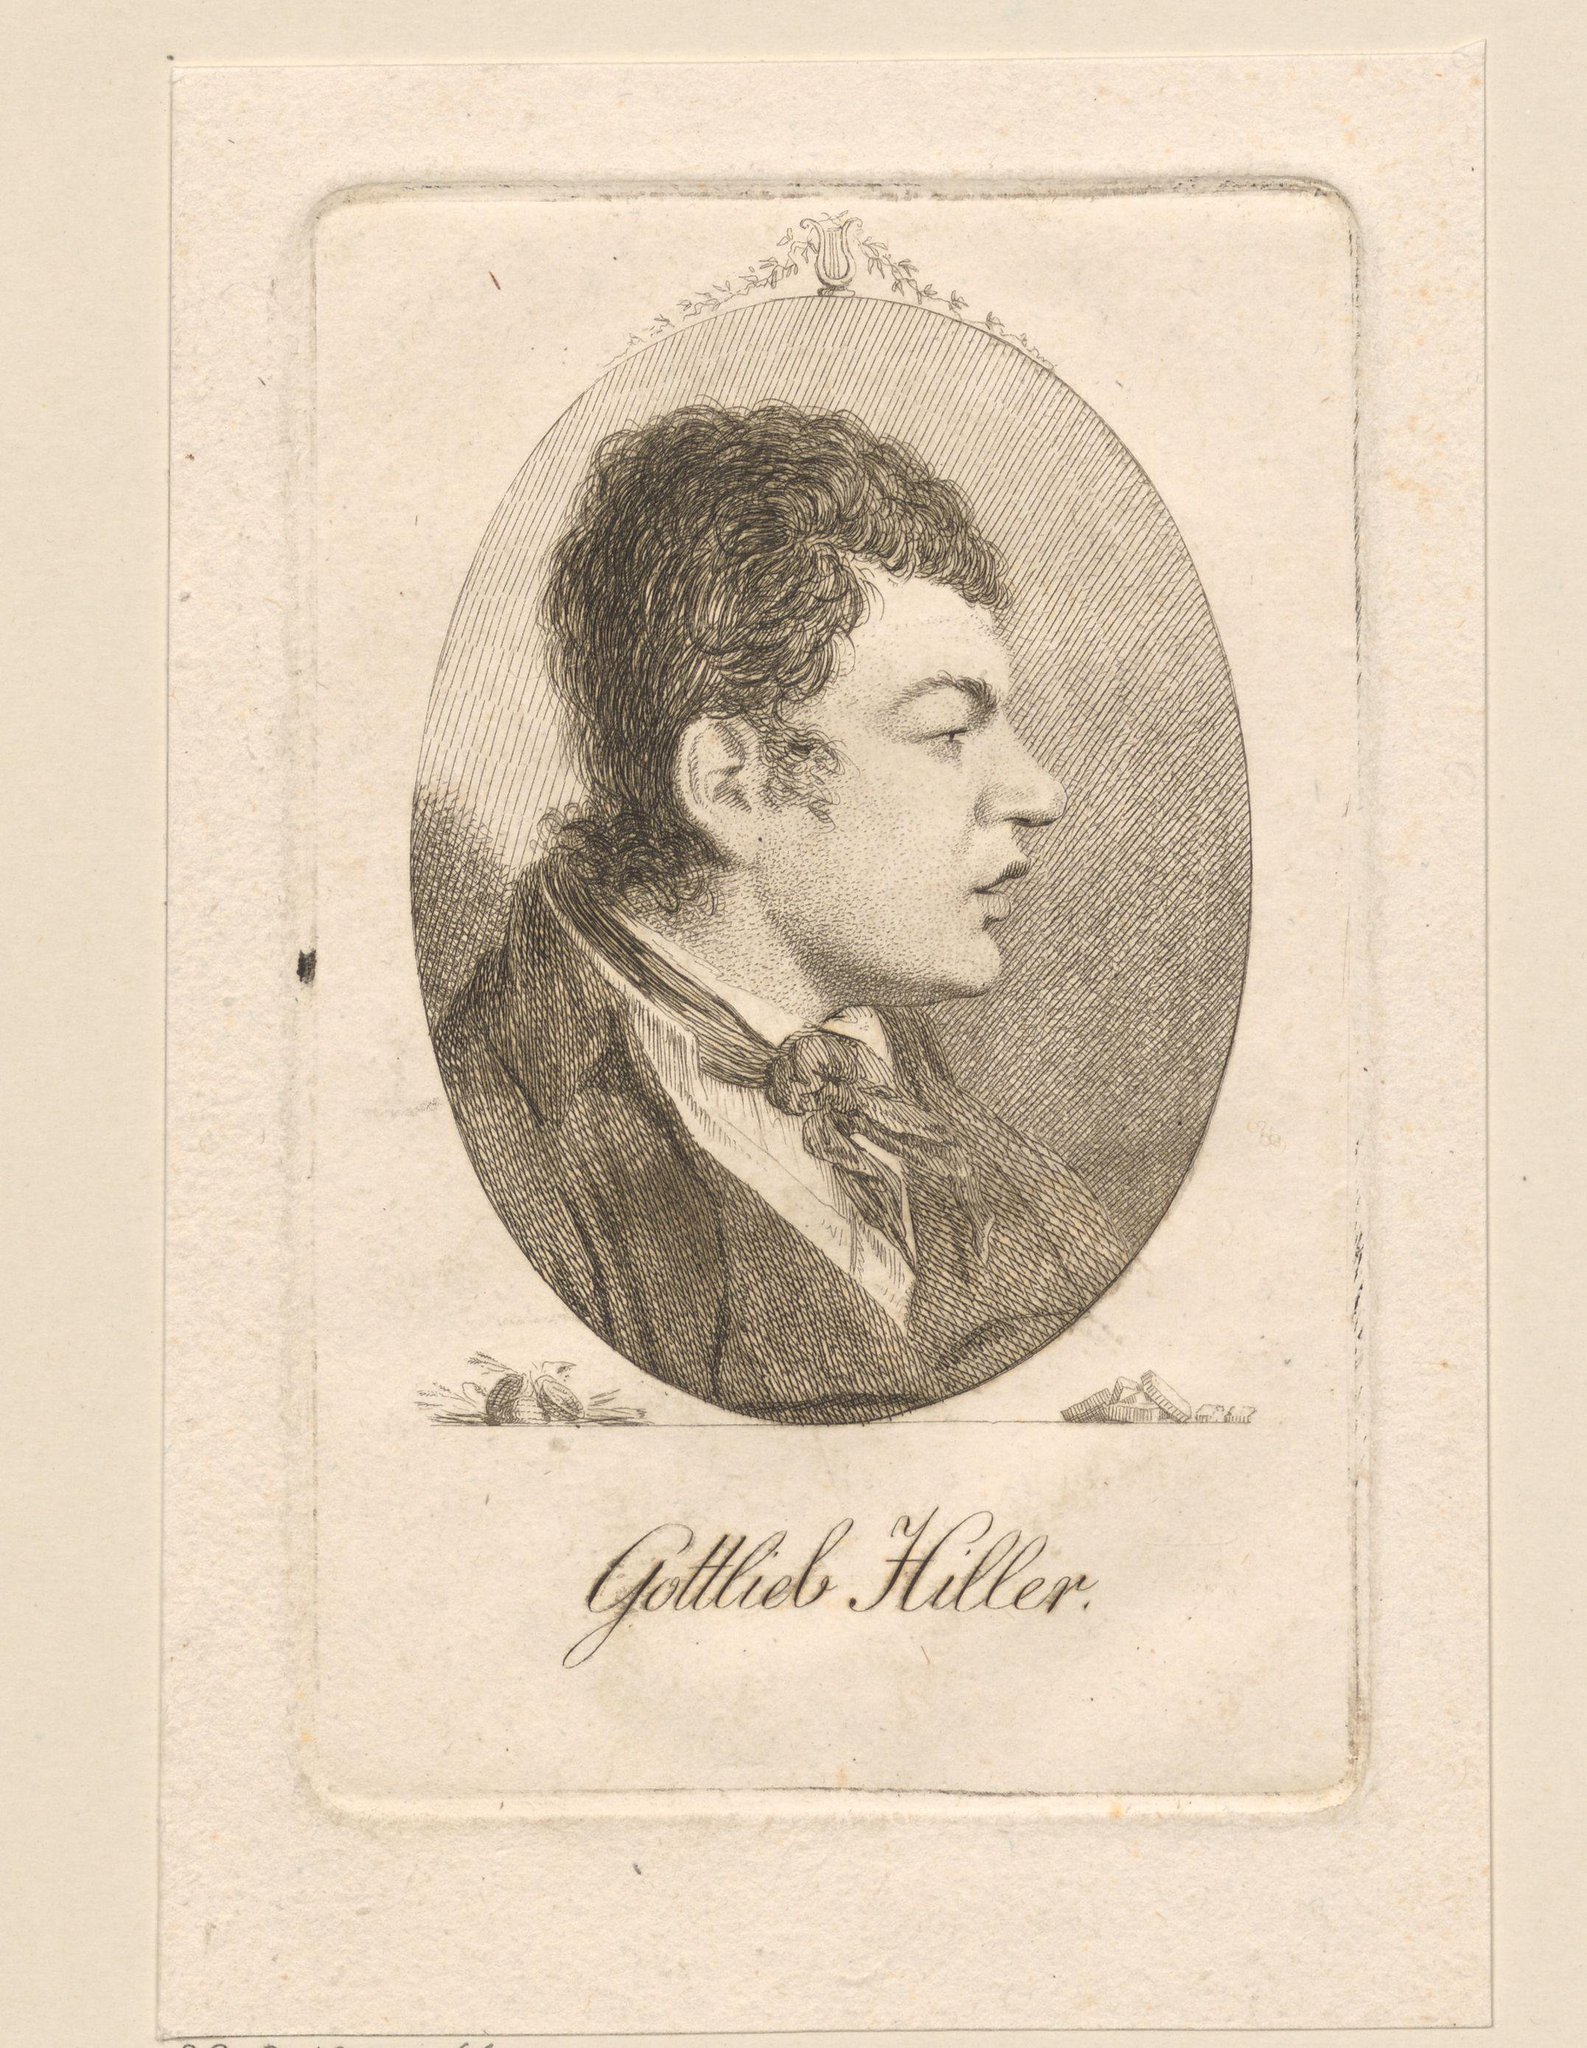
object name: print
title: Portret van Gottlieb Hiller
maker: Anonymous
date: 1800-1849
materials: paper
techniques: etching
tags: historical persons, writer, poet, author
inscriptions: collector's mark: Lugt 2228